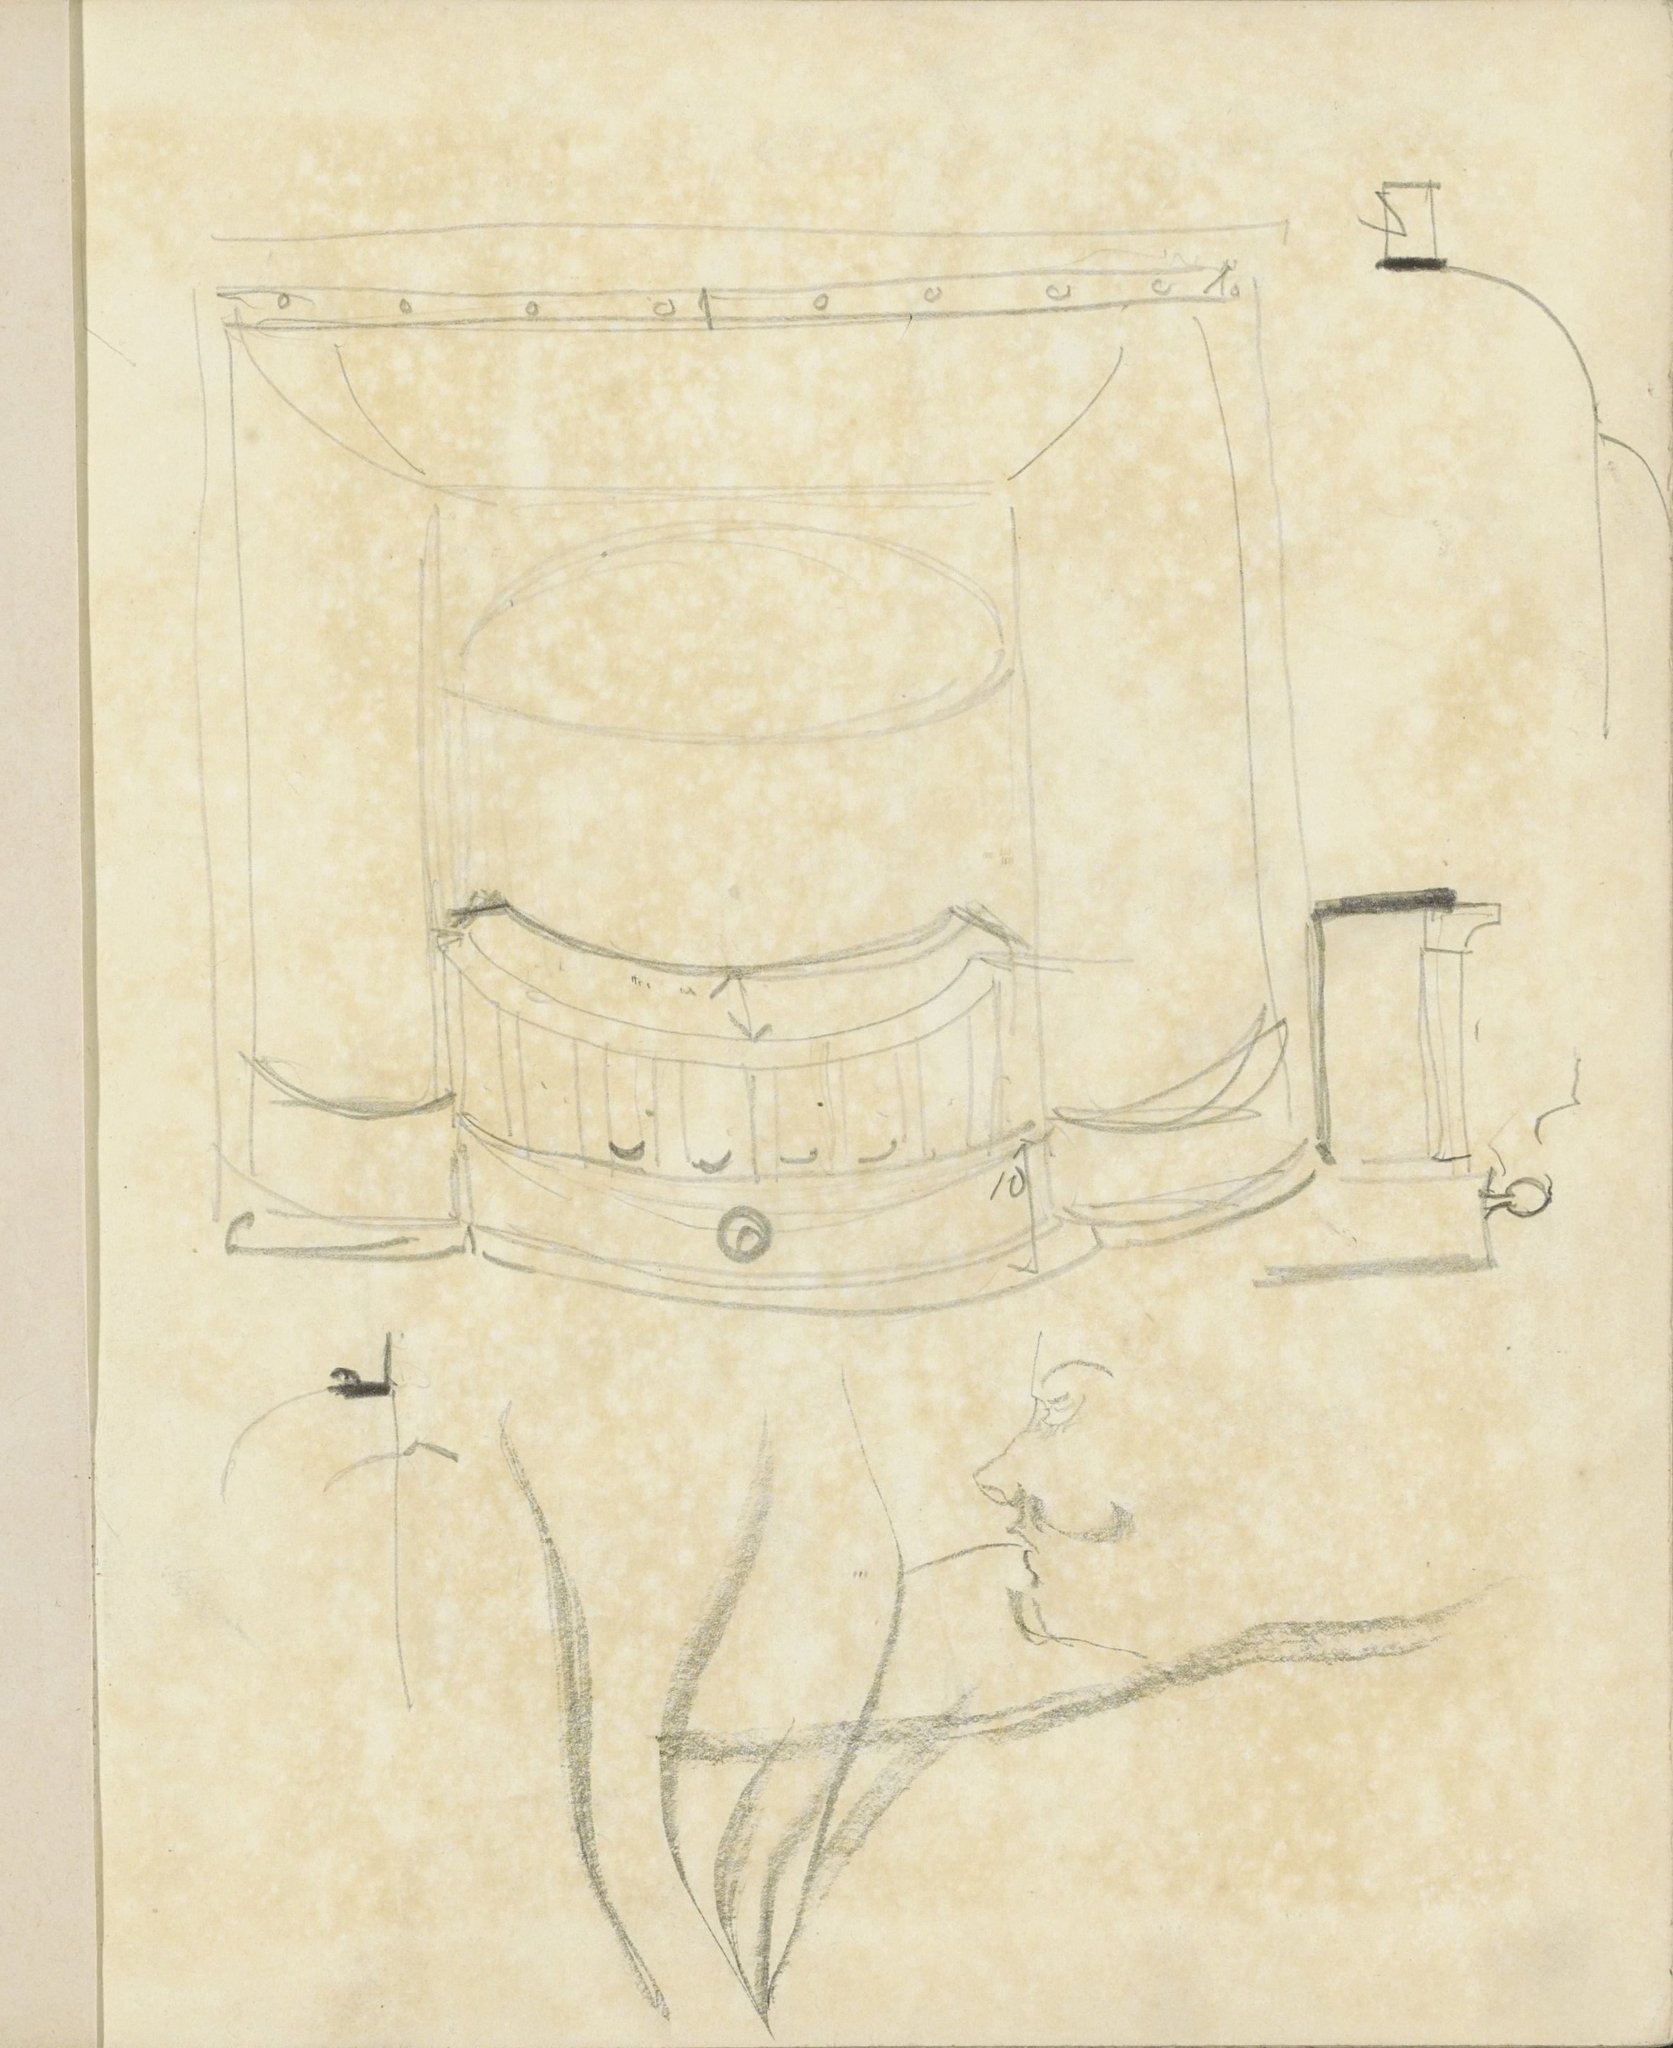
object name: sketchbook leaf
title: Ontwerp en een figuurstudie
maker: carel adolph lion cachet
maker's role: draughtsman, print maker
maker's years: 1864-1945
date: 1900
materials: paper, pencil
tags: head (human), architectural representations in general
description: Blad 2 recto uit een schetsboek met 15 bladen.